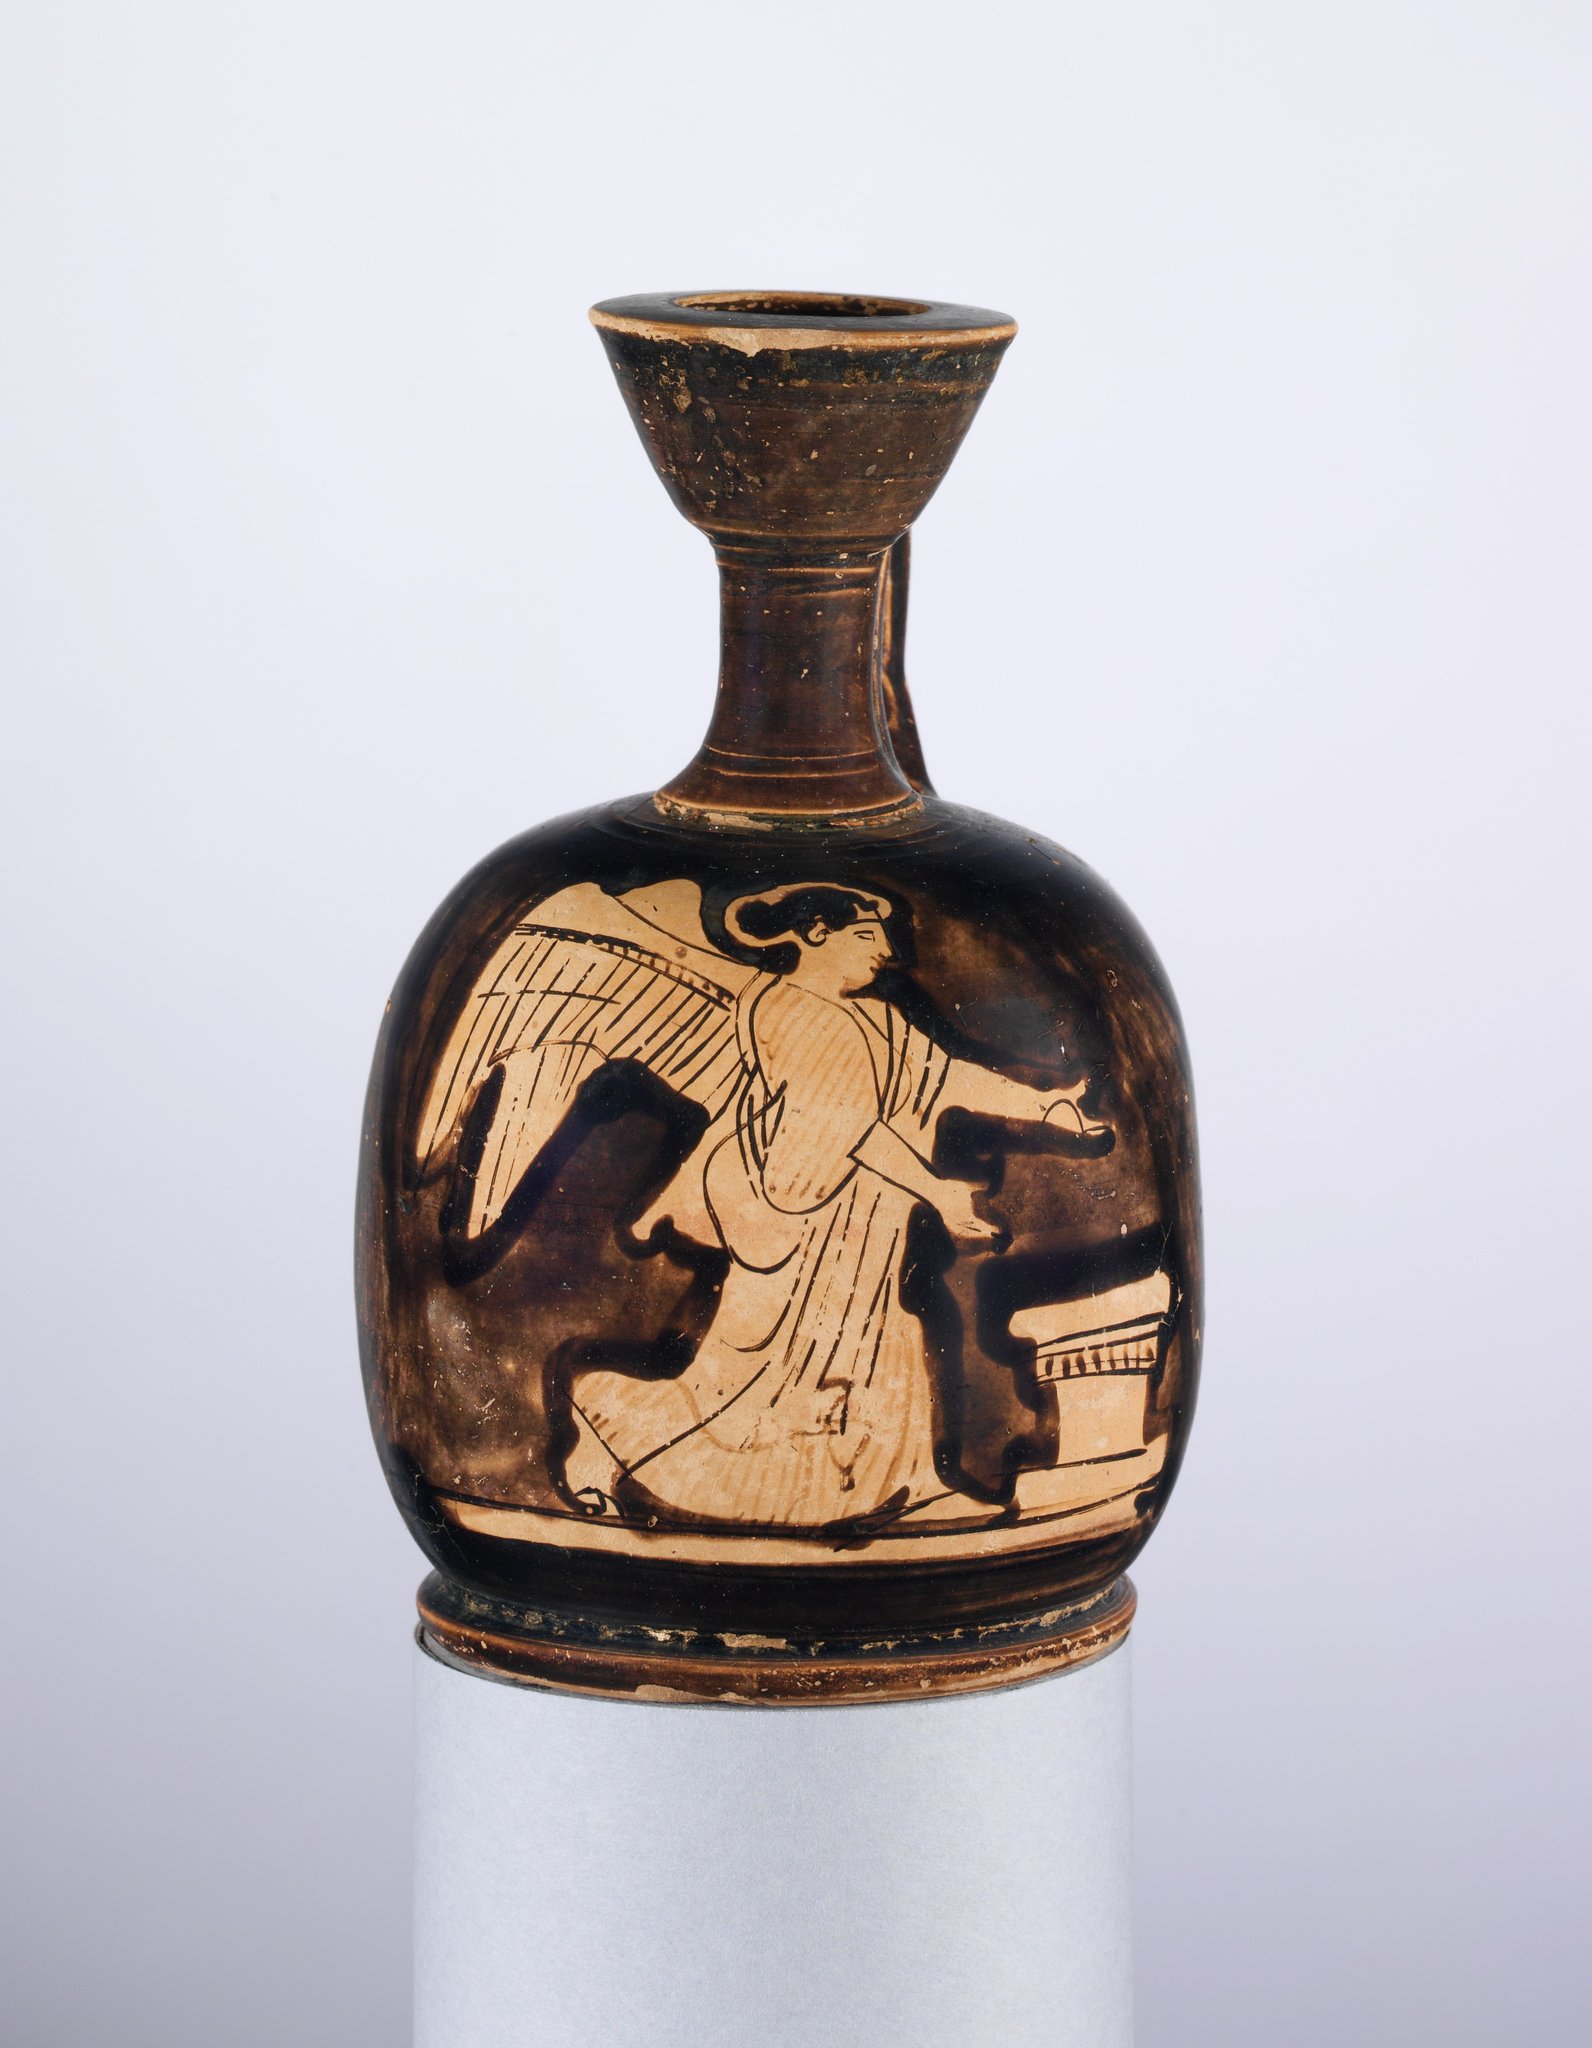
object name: squat lekythos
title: Terracotta squat lekythos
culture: greek, attic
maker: carlsruhe painter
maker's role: artist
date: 450-425 BCE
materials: terracotta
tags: altars,nike